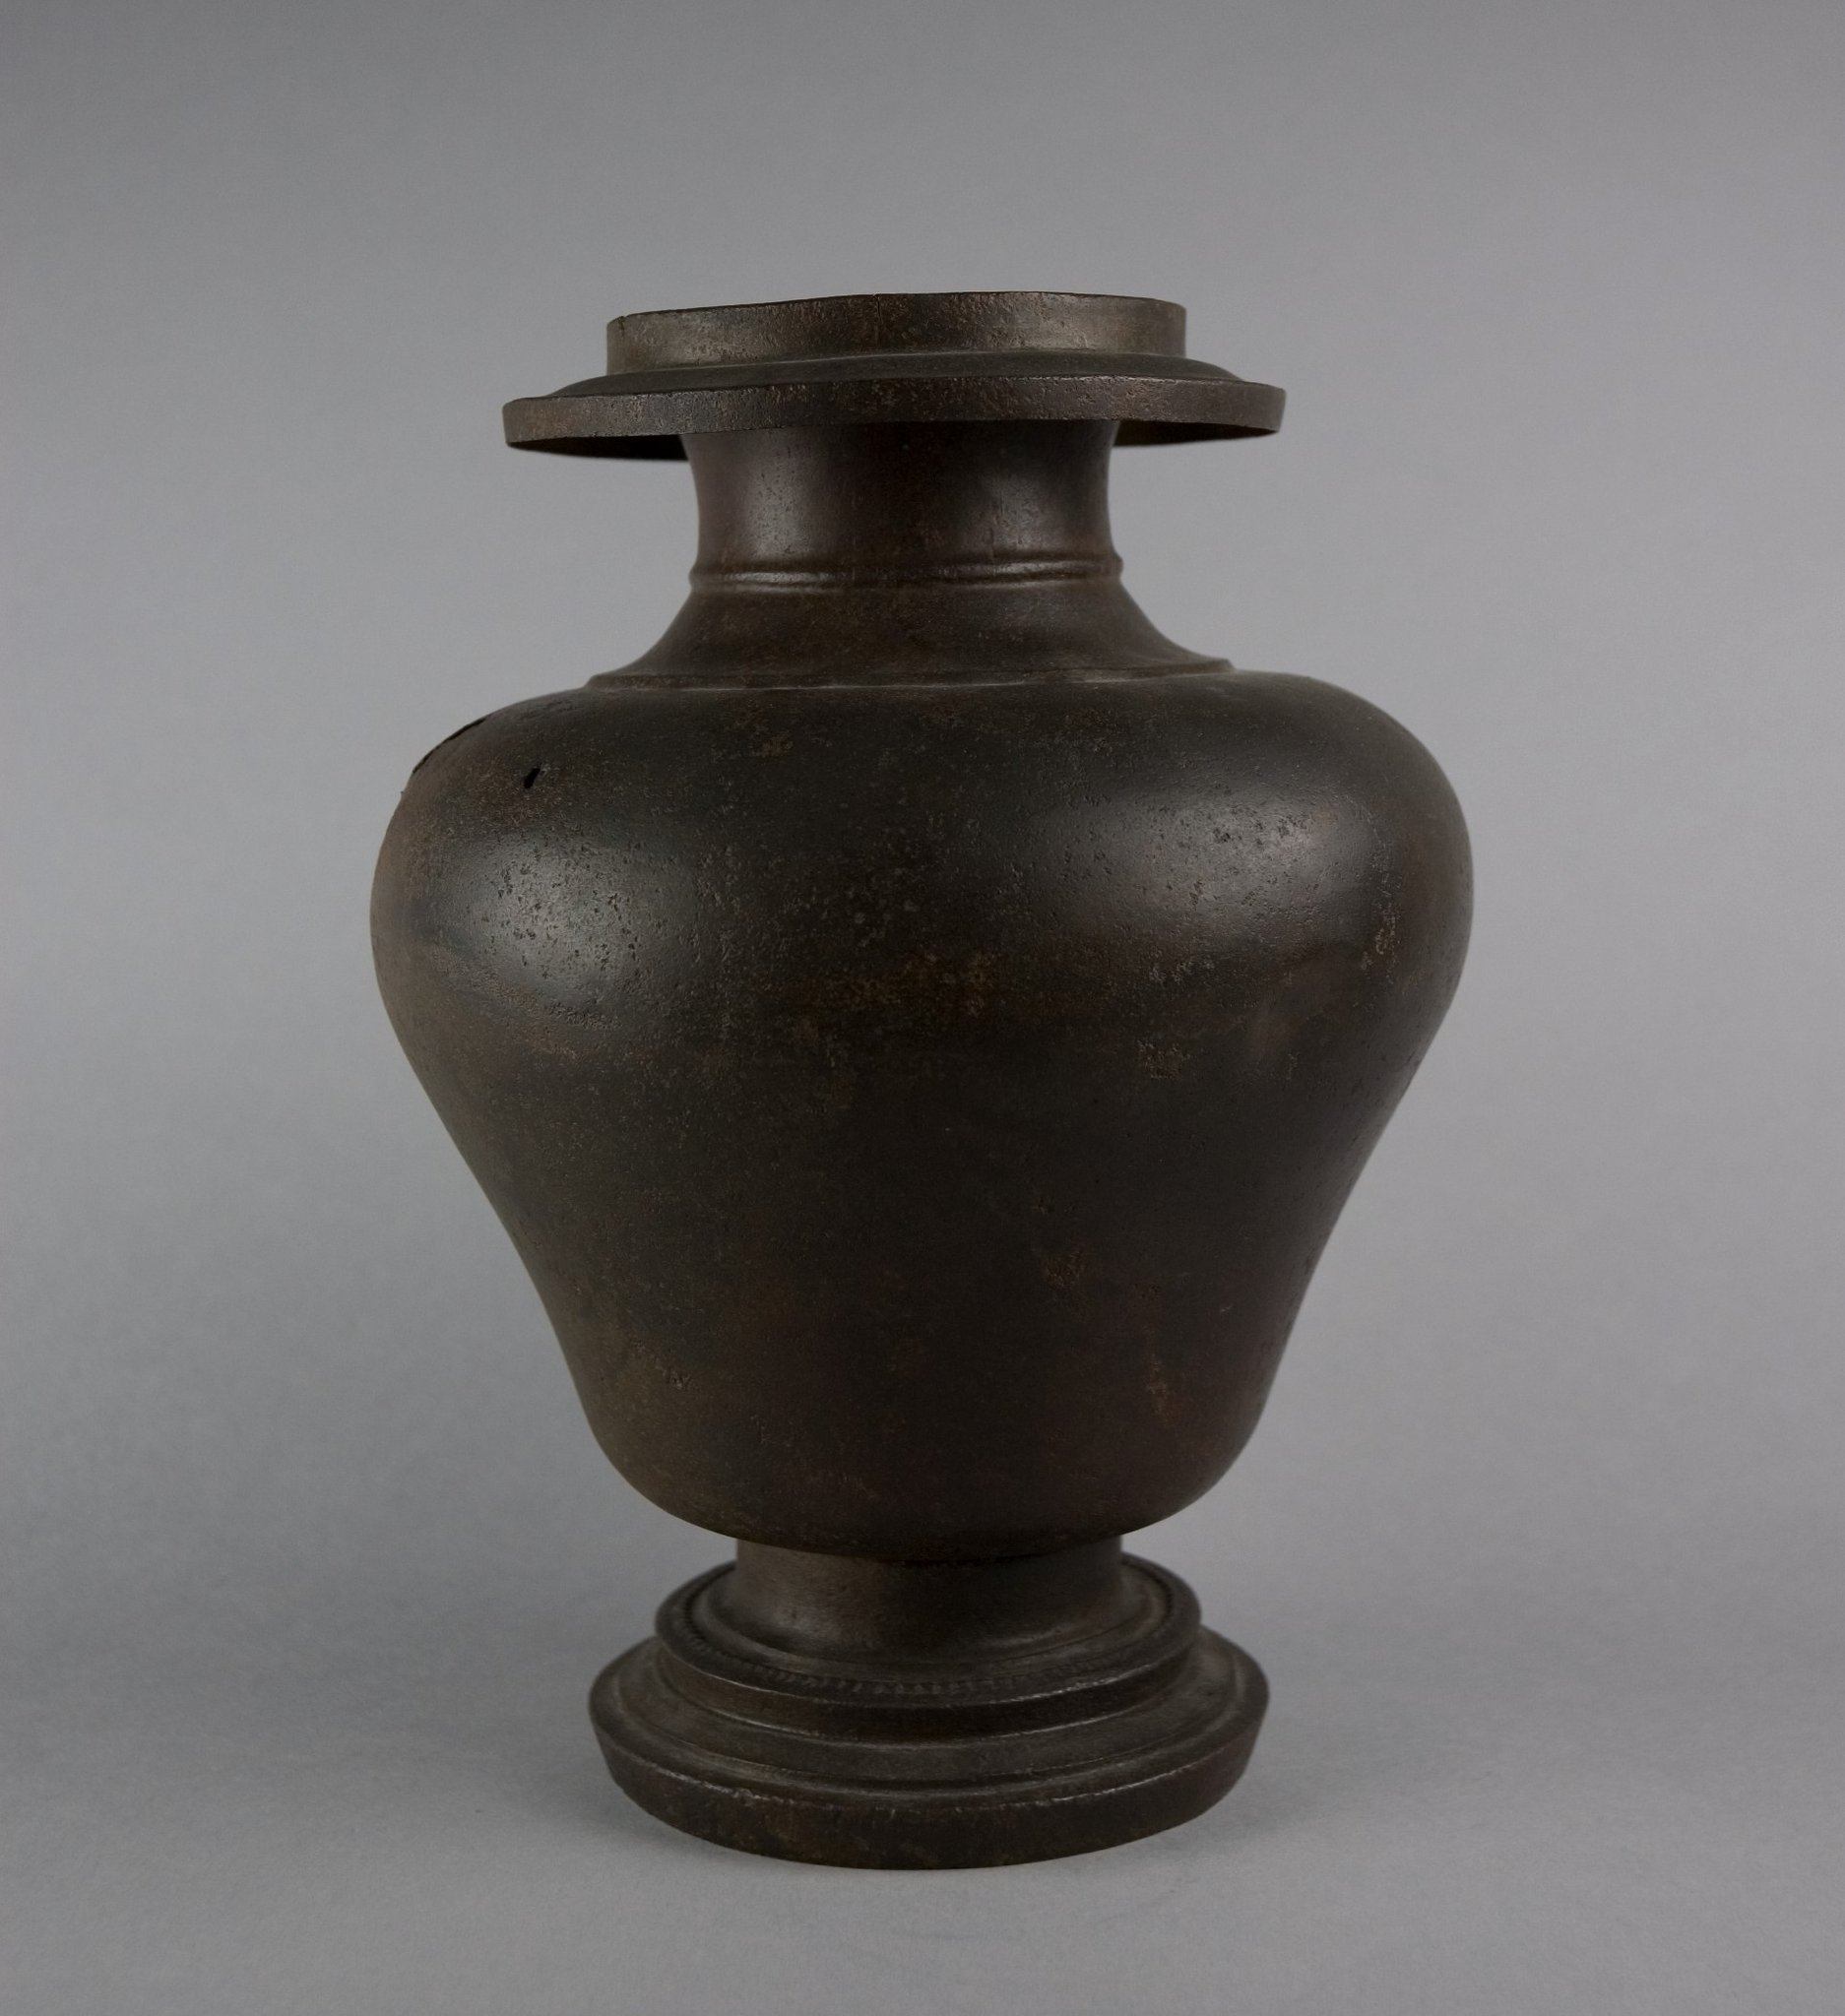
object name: vase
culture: indonesian, javanese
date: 901-1200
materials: bronze